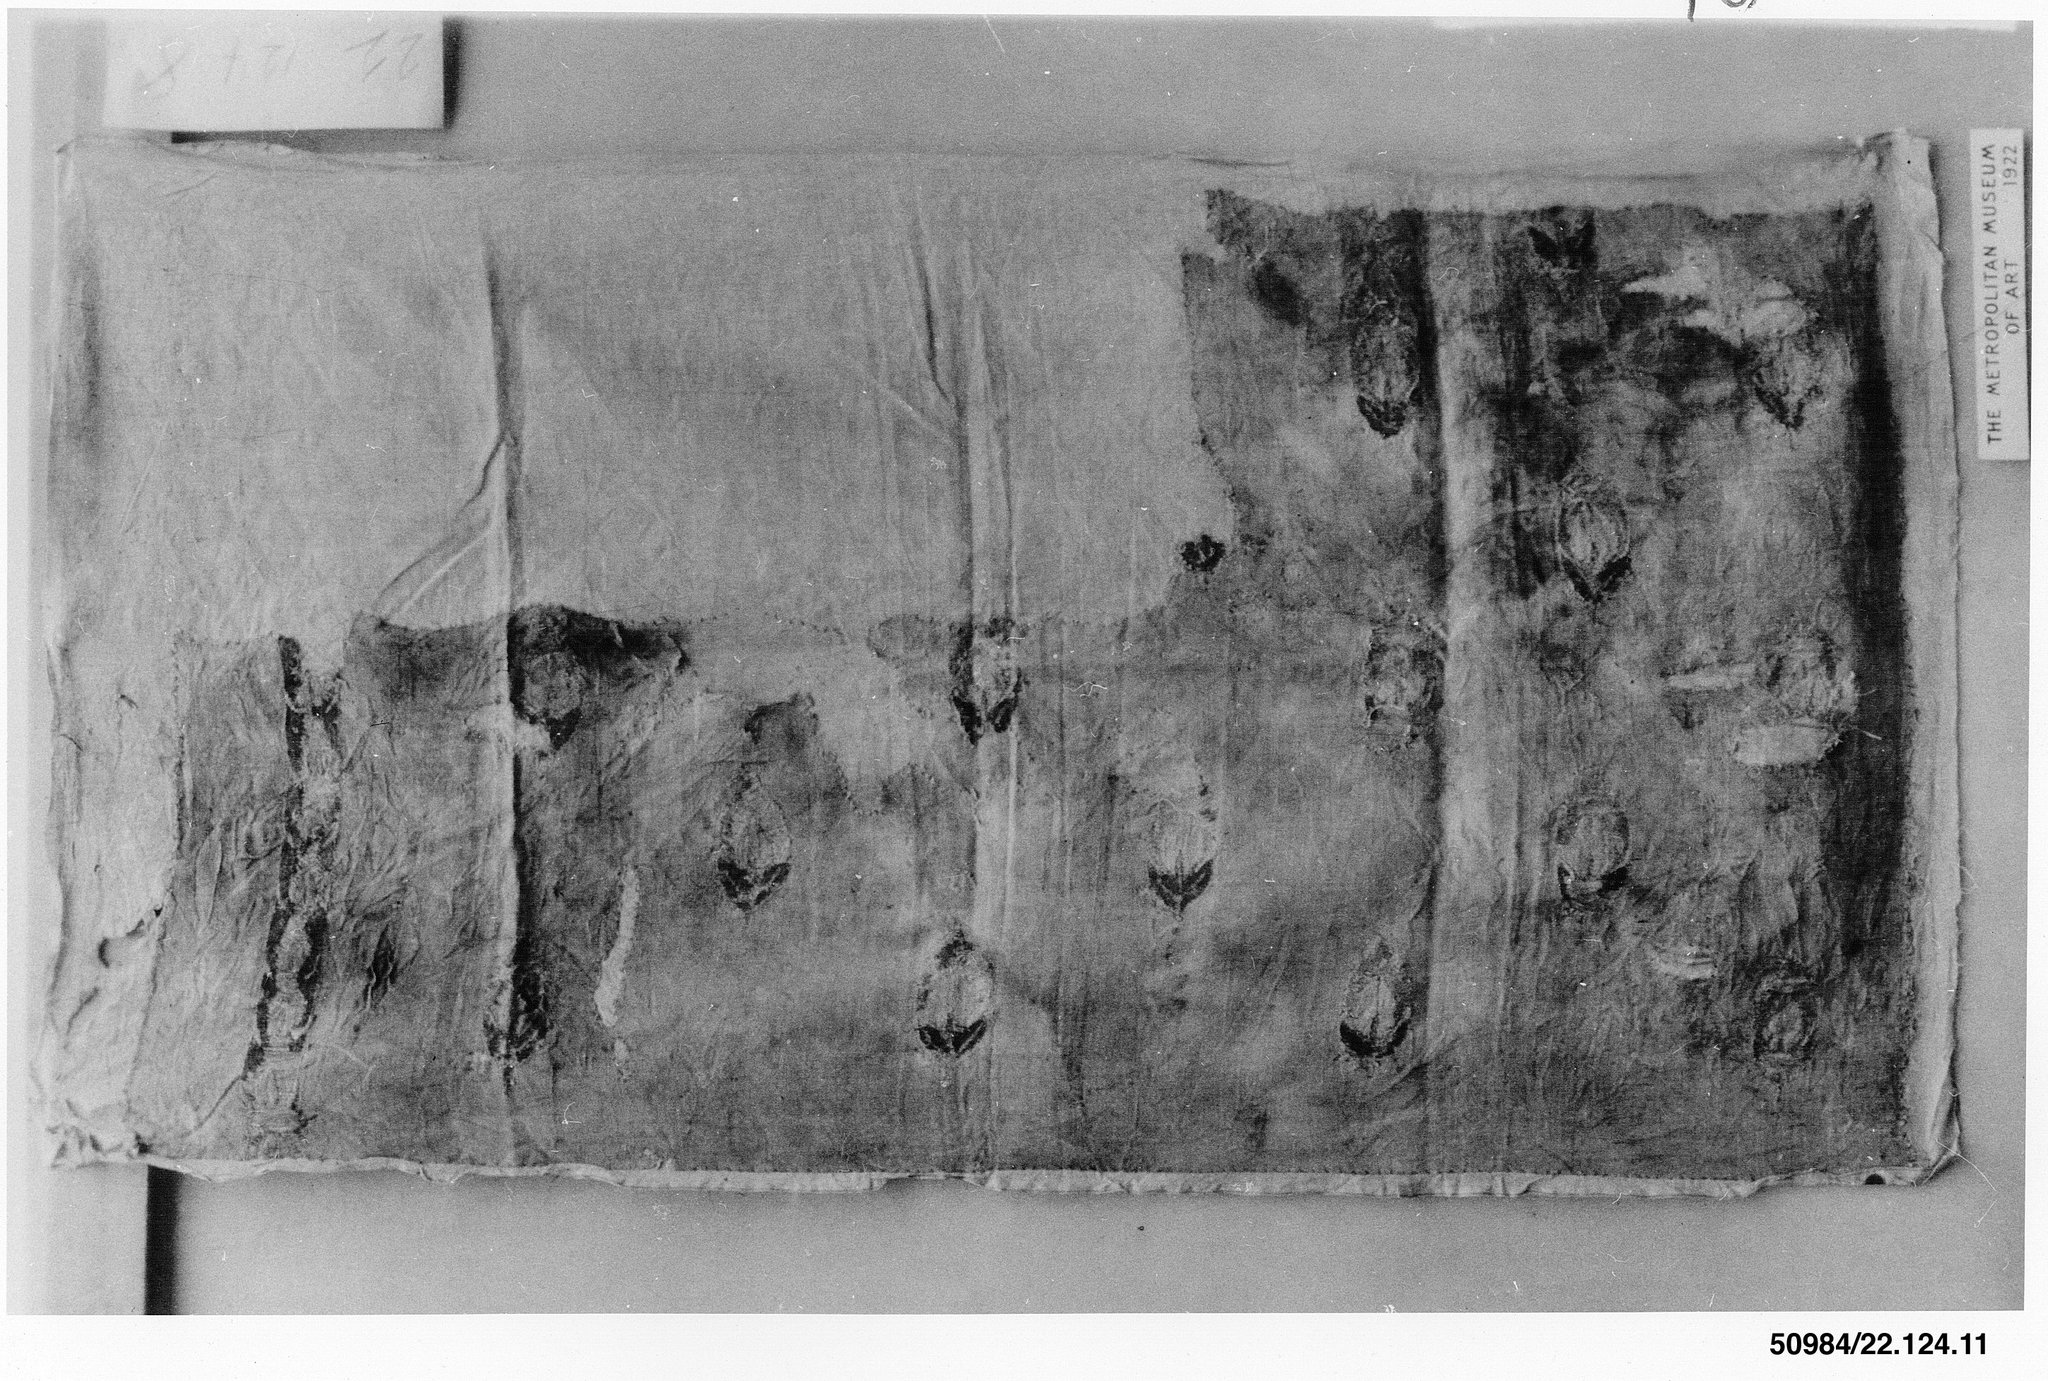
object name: fragment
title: Textile Fragment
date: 301-600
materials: linen, wool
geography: egypt